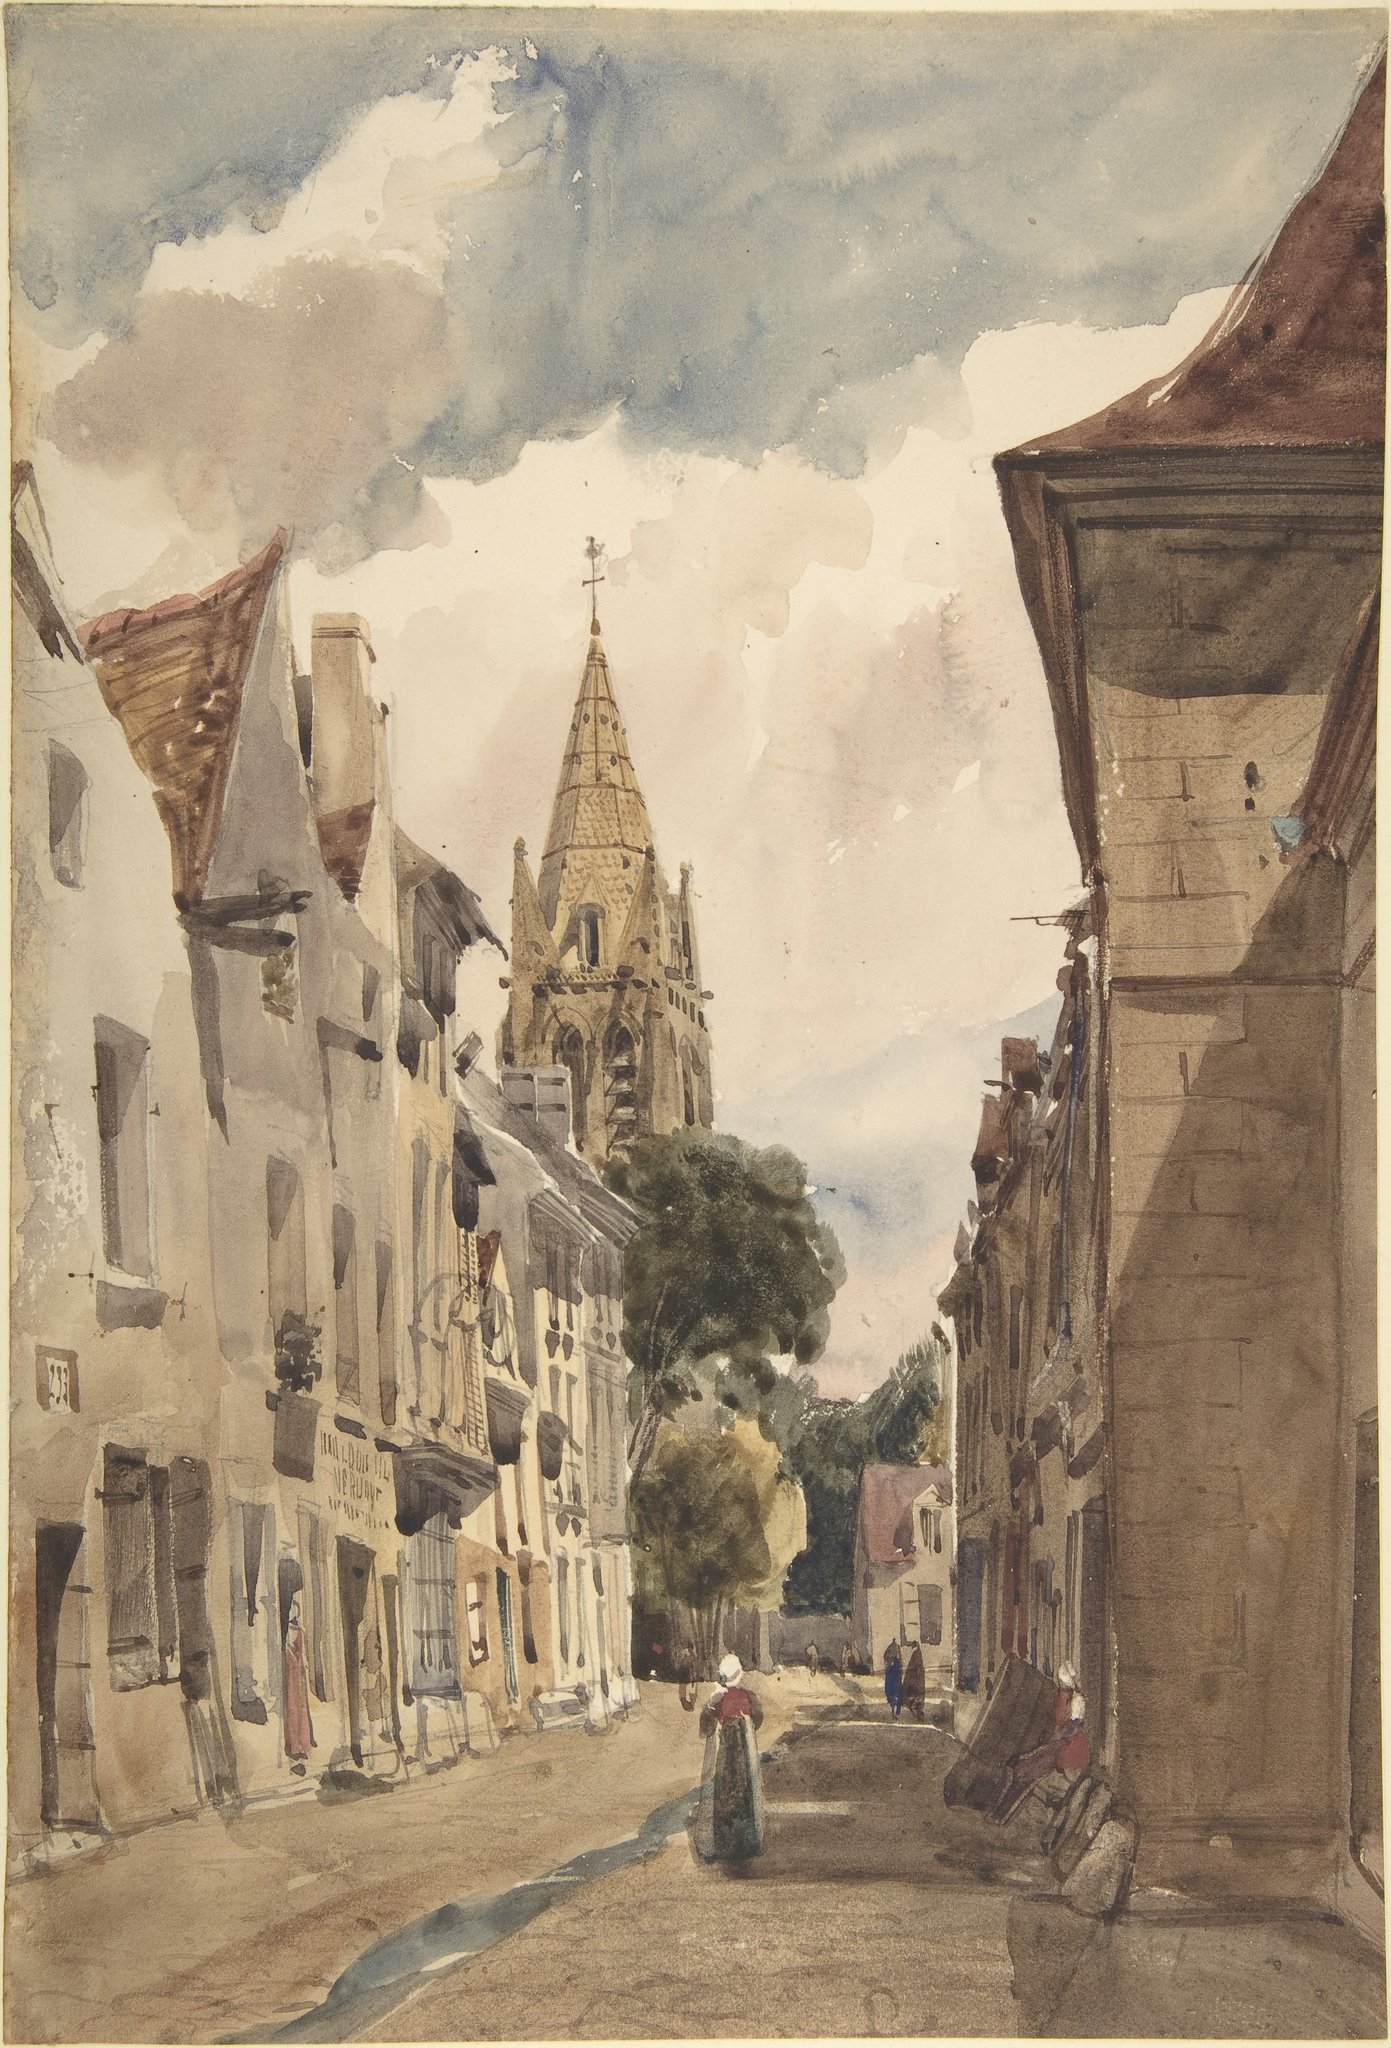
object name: drawing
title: View of Issy (A Street in Issy-les-Moulineaux, Seine)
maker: thomas shotter boys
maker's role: artist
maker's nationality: british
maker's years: 1803-1874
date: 1820-1874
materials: graphite, watercolor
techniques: brush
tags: human figures,buildings,streets,churches